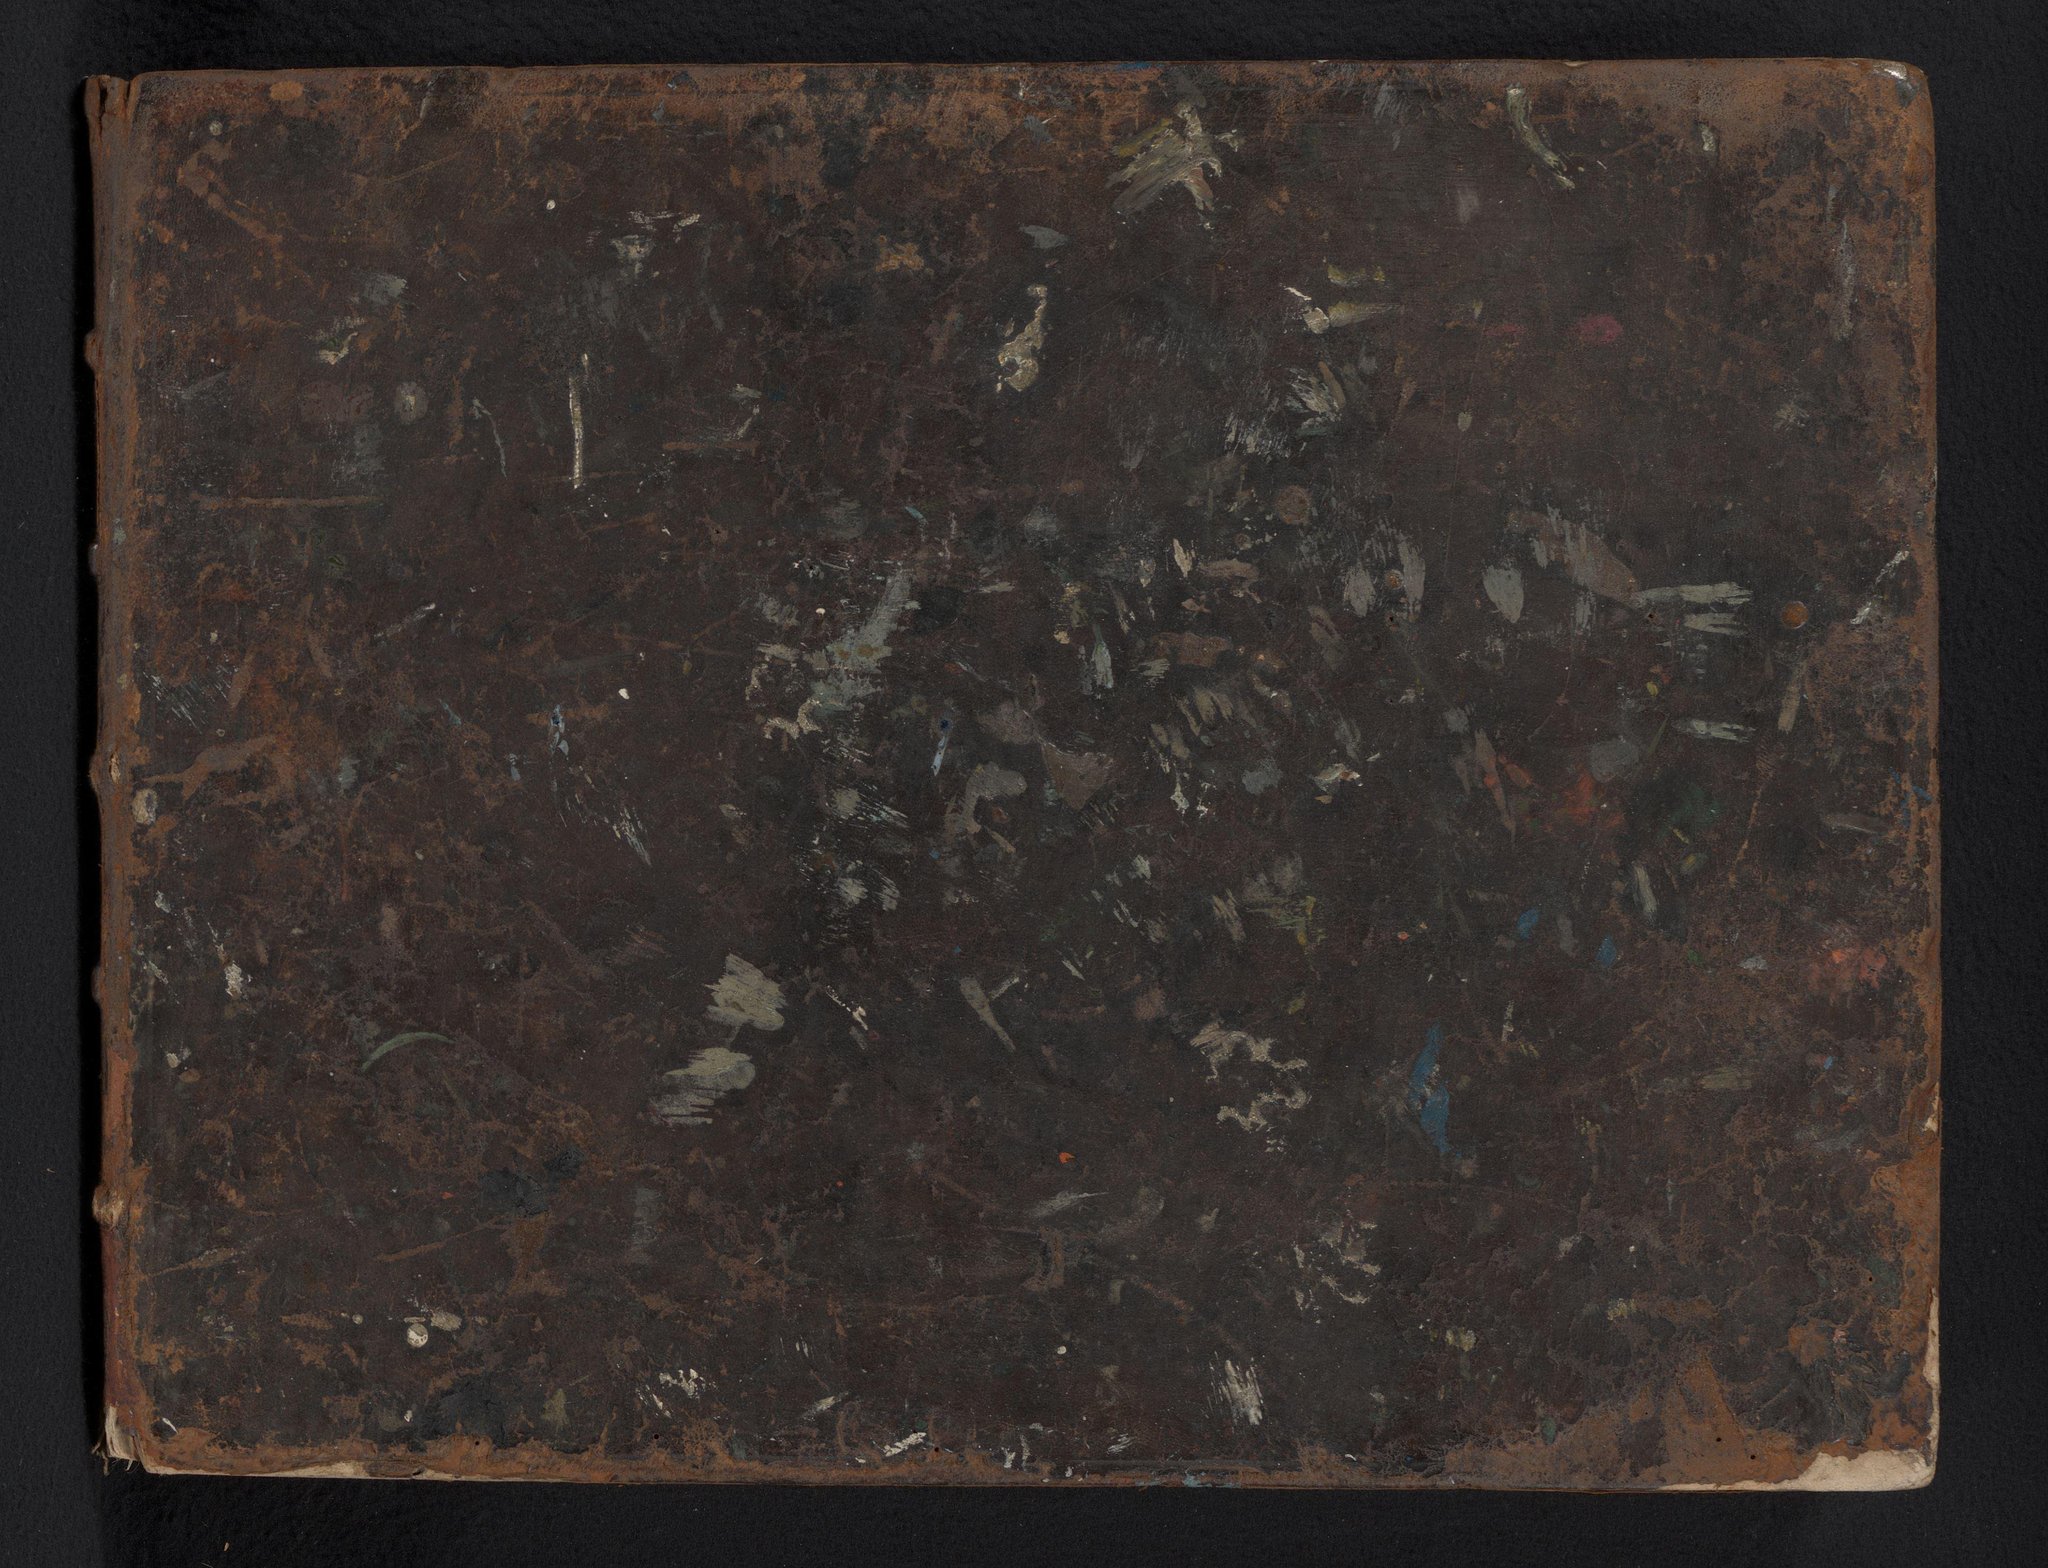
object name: prentrecueil, prentenalbum, prentalbum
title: Album met voorstellingen van het verleden en heden van Zweden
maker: erik jönssen dahlberg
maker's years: 1625-1703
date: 1661-1715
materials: leather, paper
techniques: engraving, etching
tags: zweden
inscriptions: collector's mark: ‘RIJKS / MUSM’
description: Album met 355 voorstellingen op 330 albumbladen. Het betreffen afbeeldingen van Zweden uitgegeven onder de titel: Suecia antiqua et hodierna. Aan het eind een Index op vier bladen (13 pagina's). Leren band, voorin en achterin een schutblad.